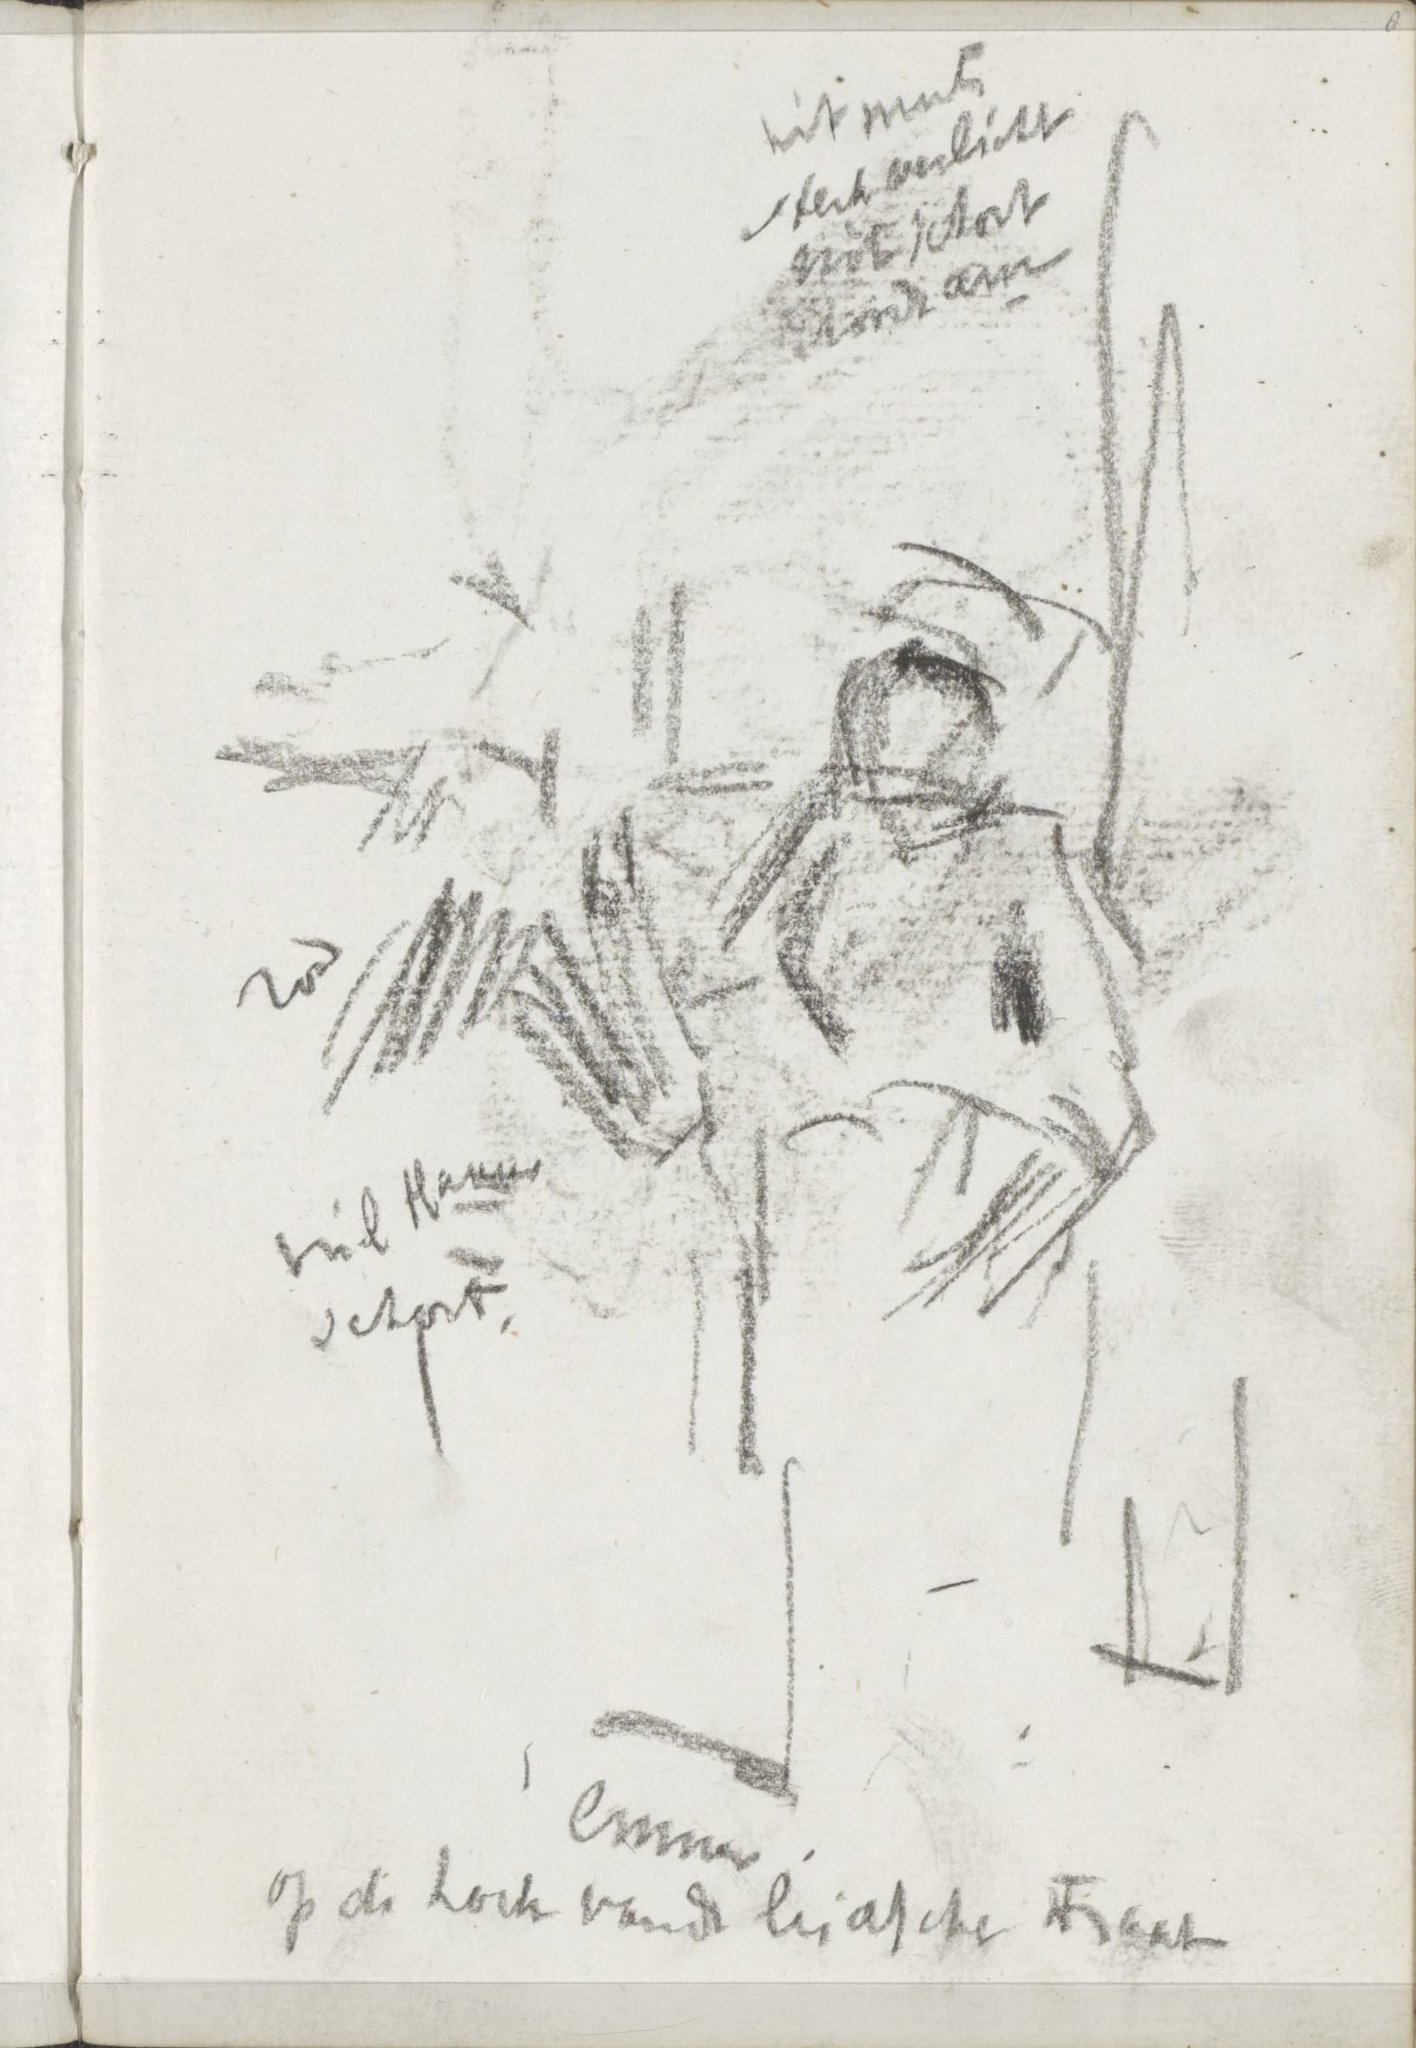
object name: sketchbook leaf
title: Twee vrouwen, mogelijk dienstmeiden, in de Leidsestraat te Amsterdam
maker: george hendrik breitner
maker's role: draughtsman, painter, print maker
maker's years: 1857-1923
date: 1886-1895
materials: chalk, paper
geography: amsterdam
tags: adult woman (+ two persons), maid ~ house personnel, street (+ city(-scape) with figures, staffage)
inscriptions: annotation: ‘emmer/ op de hoek van de Leidsche straat’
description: Pagina 8 uit een schetsboek met 20 bladen.